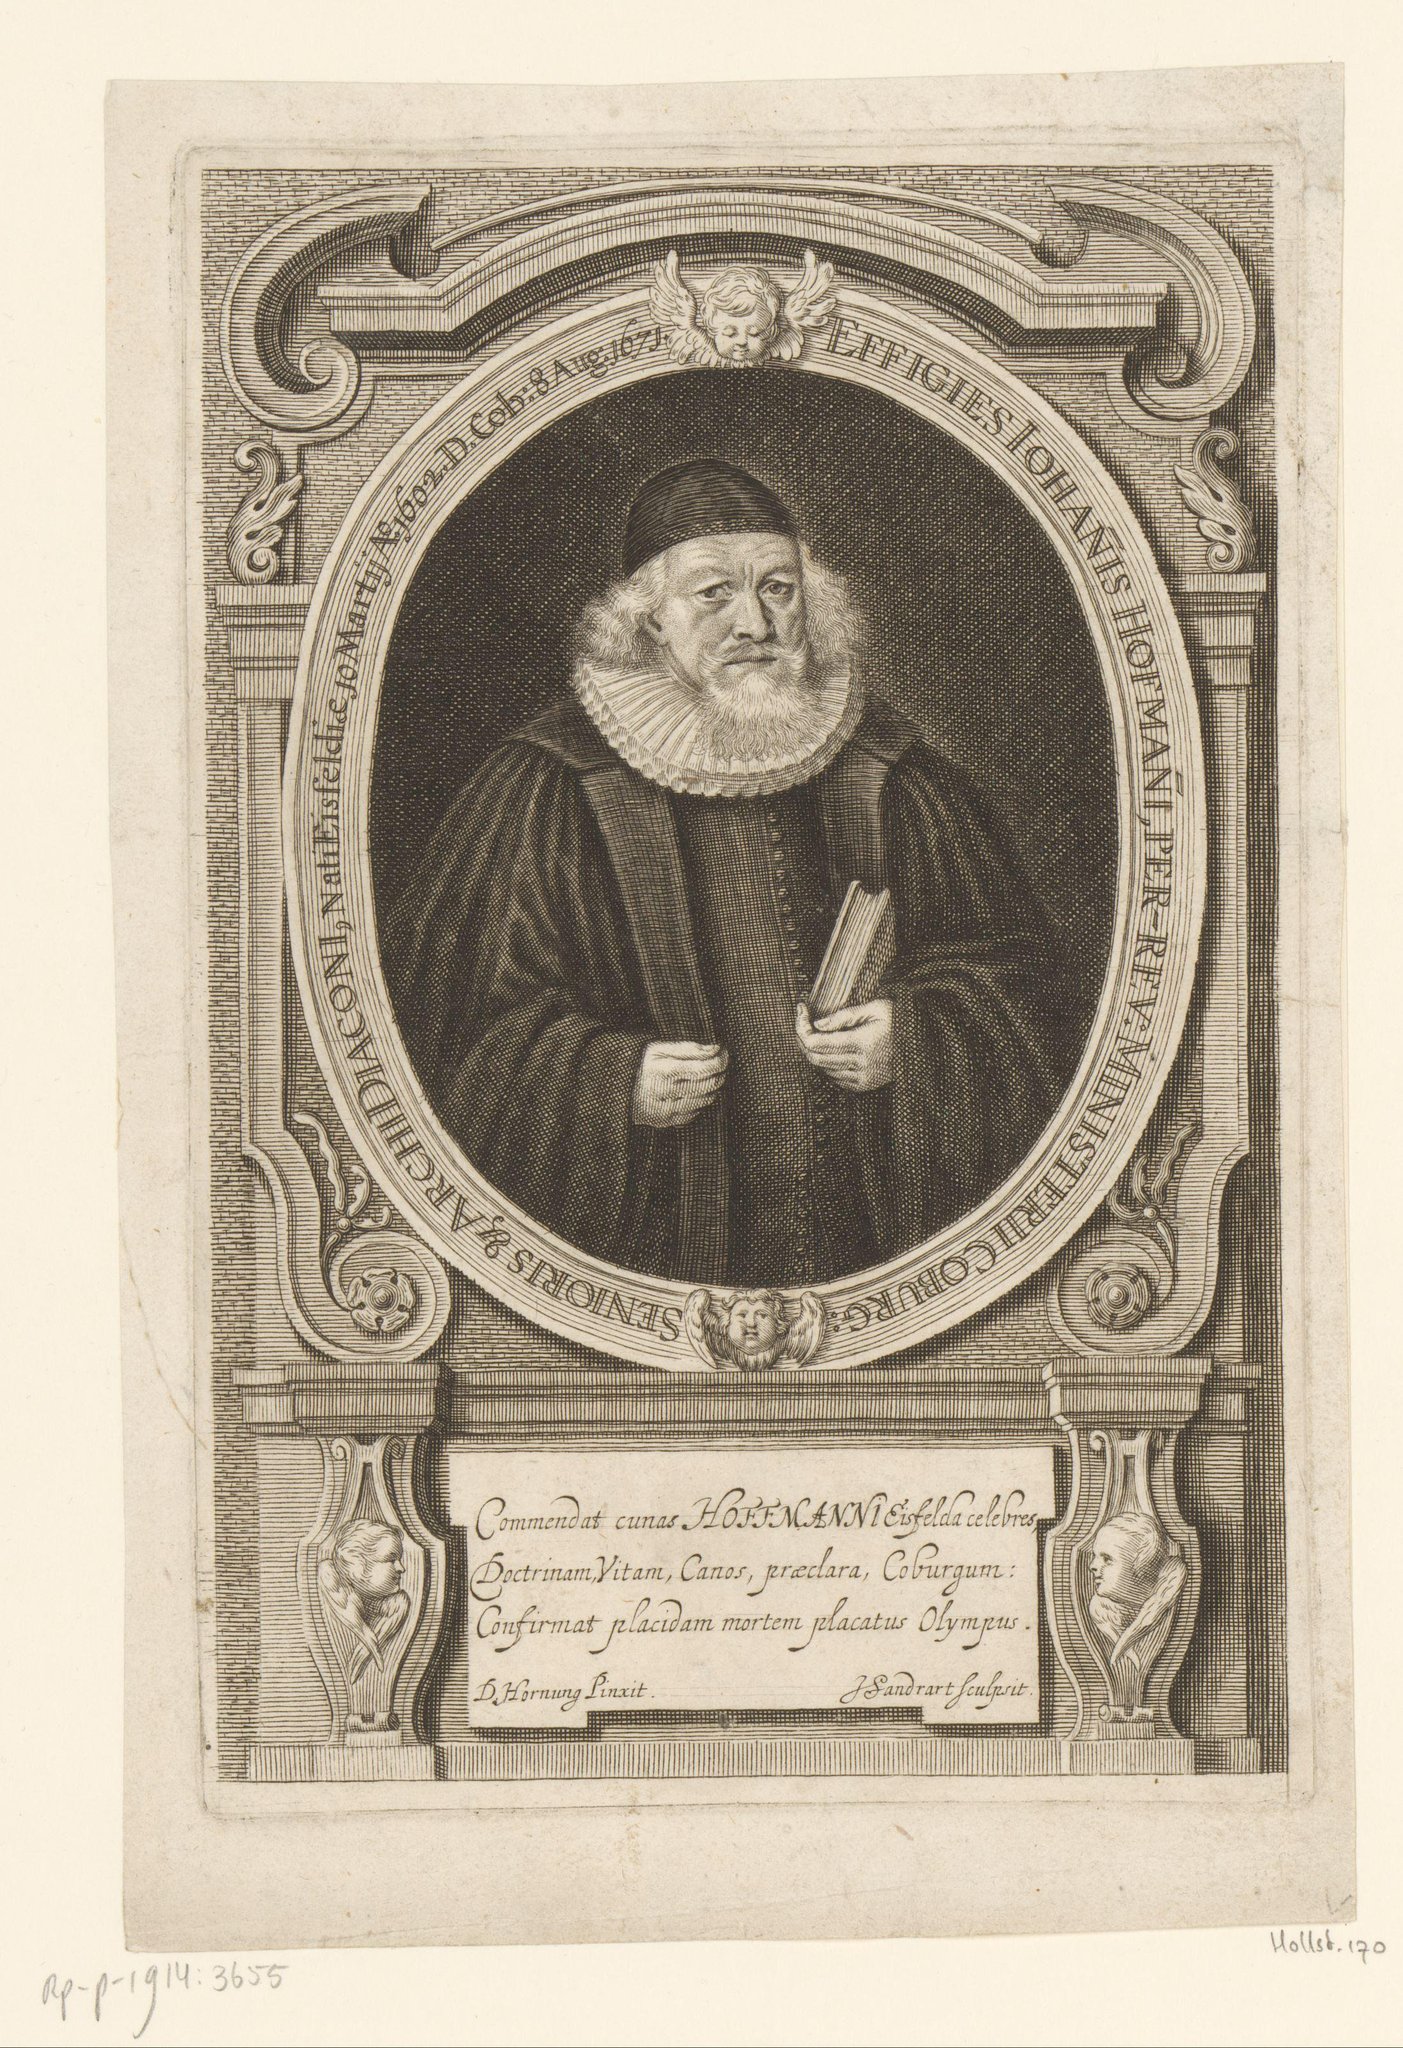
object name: print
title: Portret van Johann Hoffmann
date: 1673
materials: paper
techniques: engraving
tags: johann hoffmann (theoloog), cherubs, i.e. children's heads with wings, theologian, historical persons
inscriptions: collector's mark: Lugt 2228